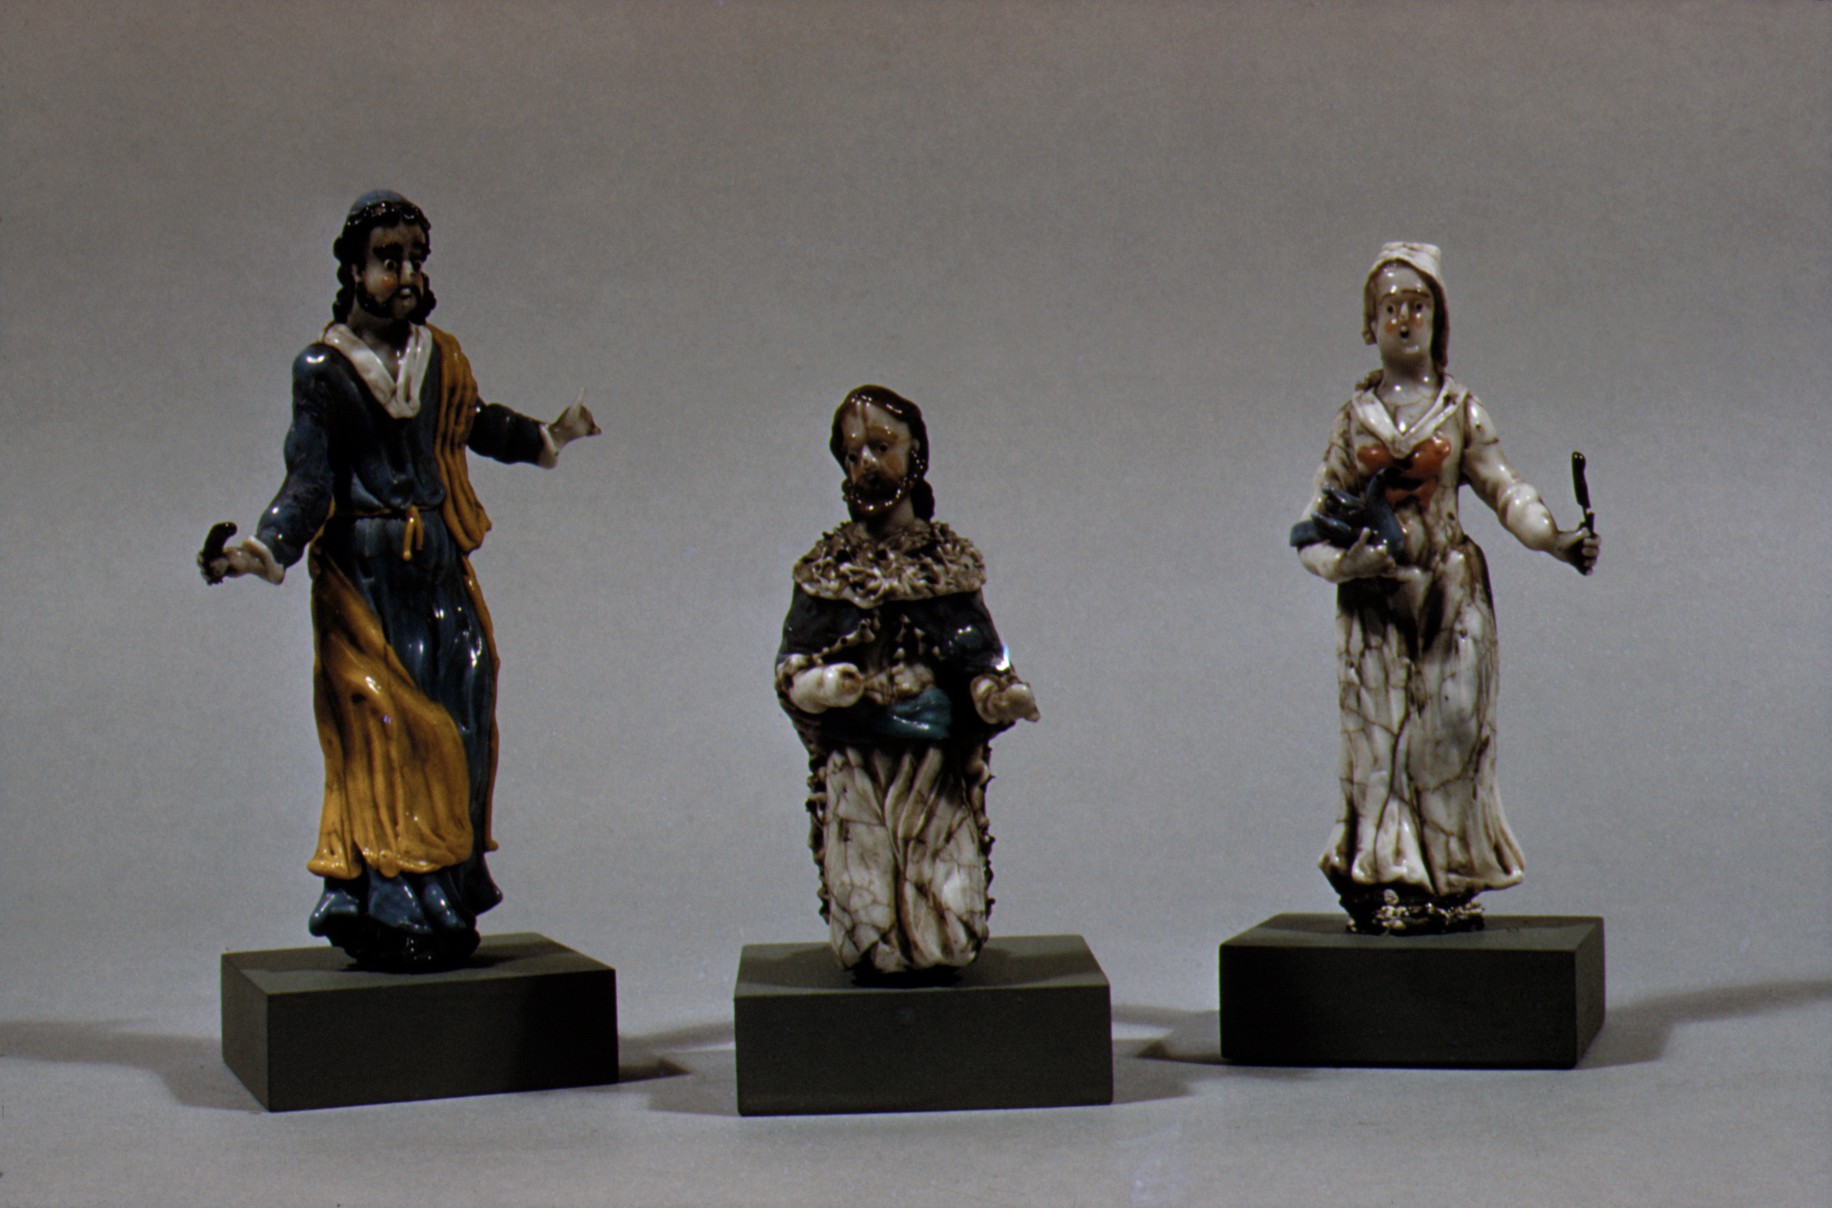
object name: statuette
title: Abraham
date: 1701-1800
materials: glass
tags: abraham